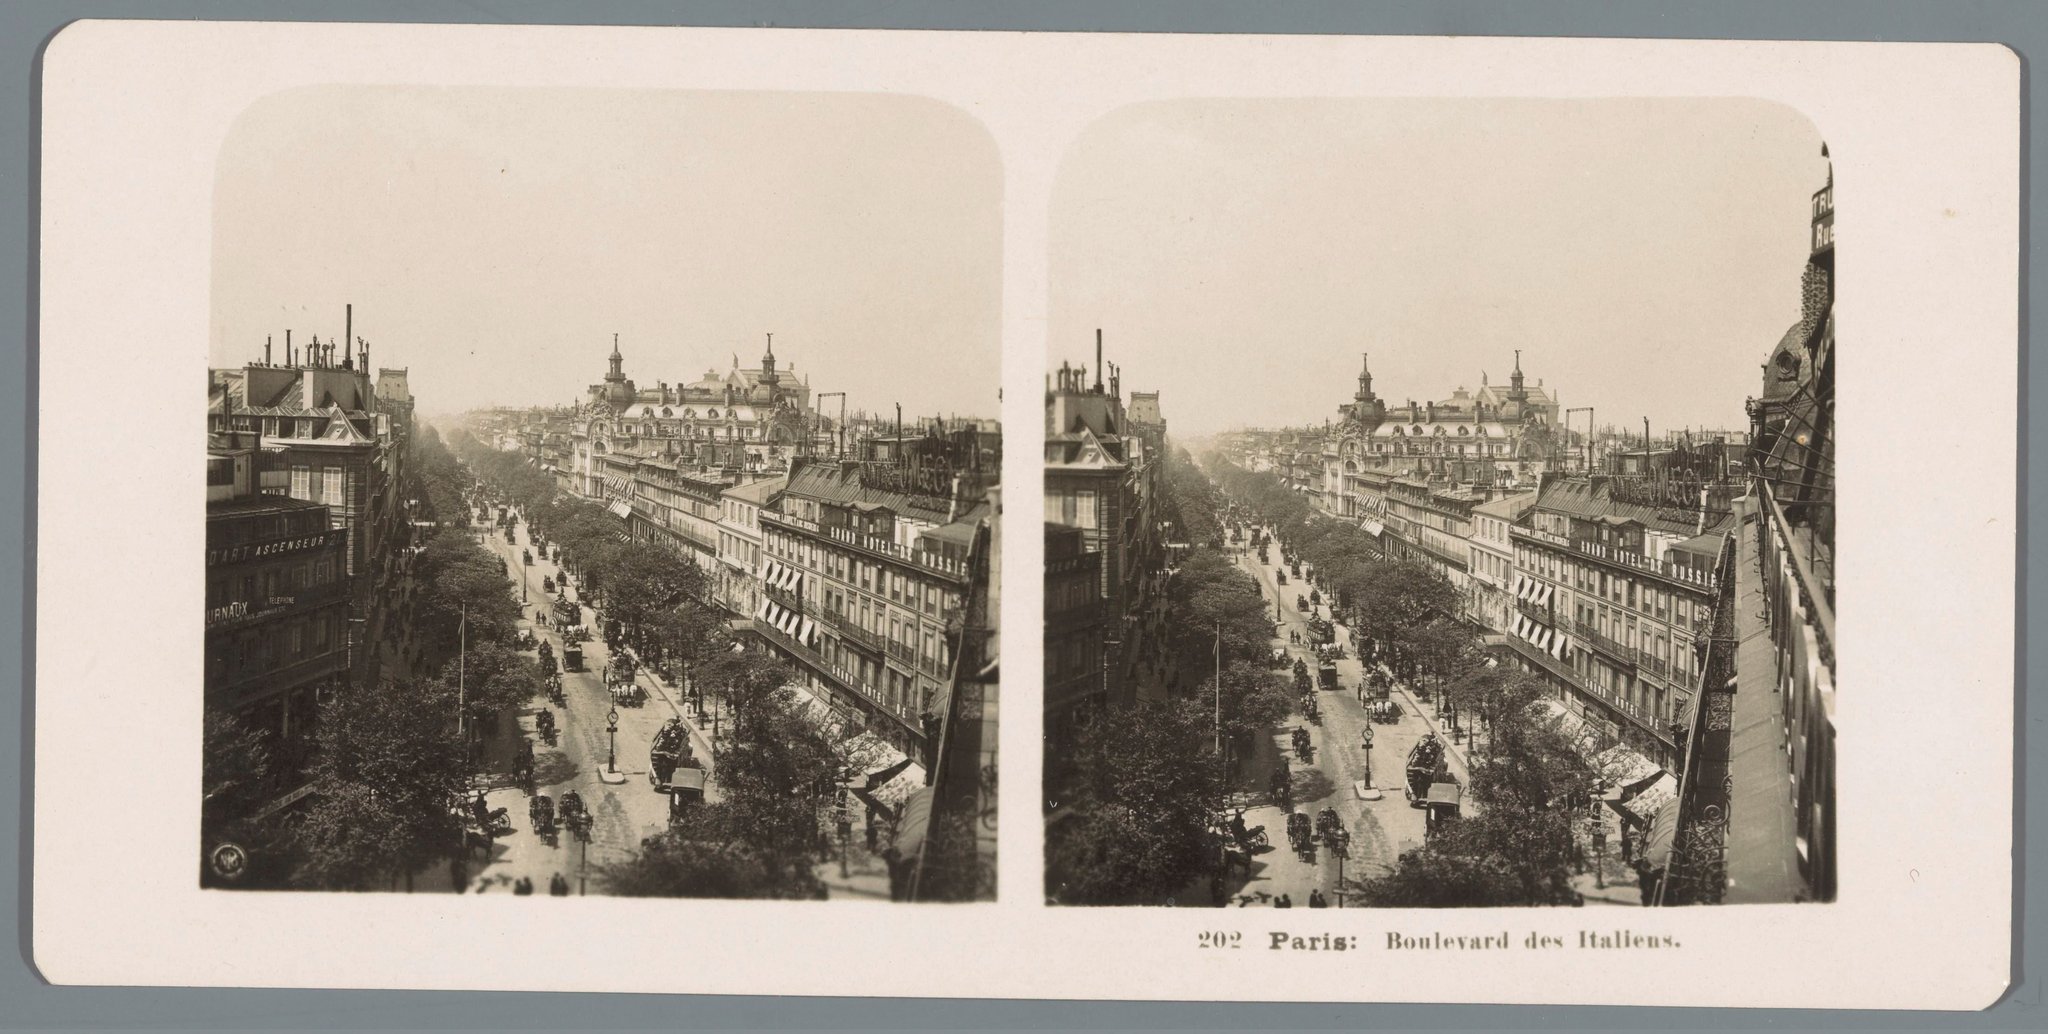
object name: stereograph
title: Gezicht op de Boulevard des Italiens te Parijs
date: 1895-1905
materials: cardboard, photographic support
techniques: gelatin silver print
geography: boulevard des italiens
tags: four-wheeled, animal-drawn vehicle, e.g.: cab, carriage, coach, avenue, boulevard, promenade, esplanade, façade (of house or building)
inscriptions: number: ‘202’, inscription: ‘NPG’